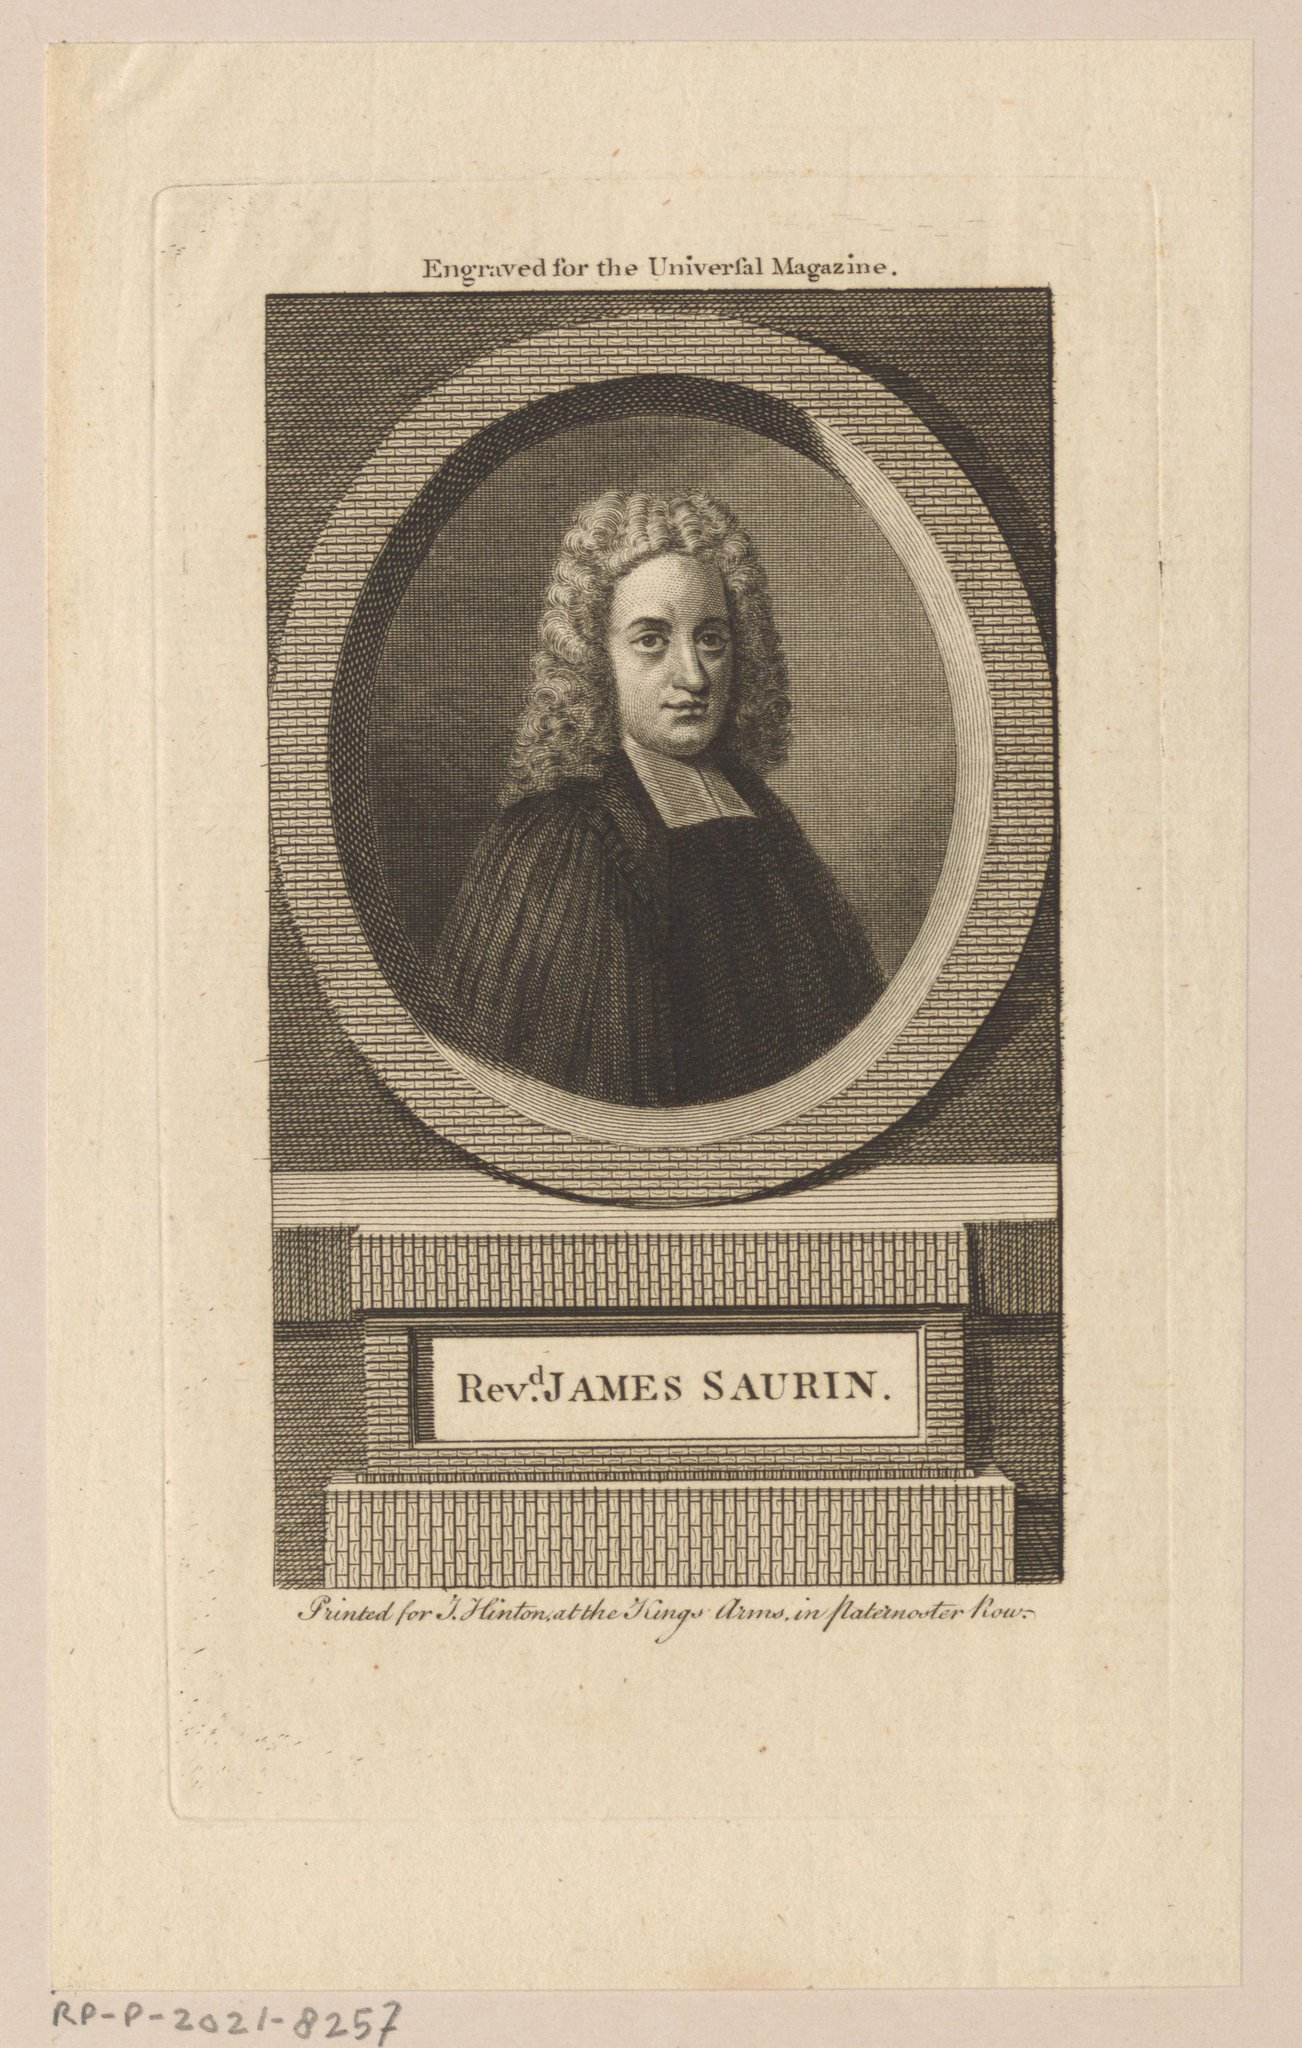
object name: print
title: Portret van Jacques Saurin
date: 1781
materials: paper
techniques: etching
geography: london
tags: protestant churches and denominations, historical persons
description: Prent gebruikt als bijlage in: The Universal Magazine of Knowledge and Pleasure 69 (1781), december 1781.